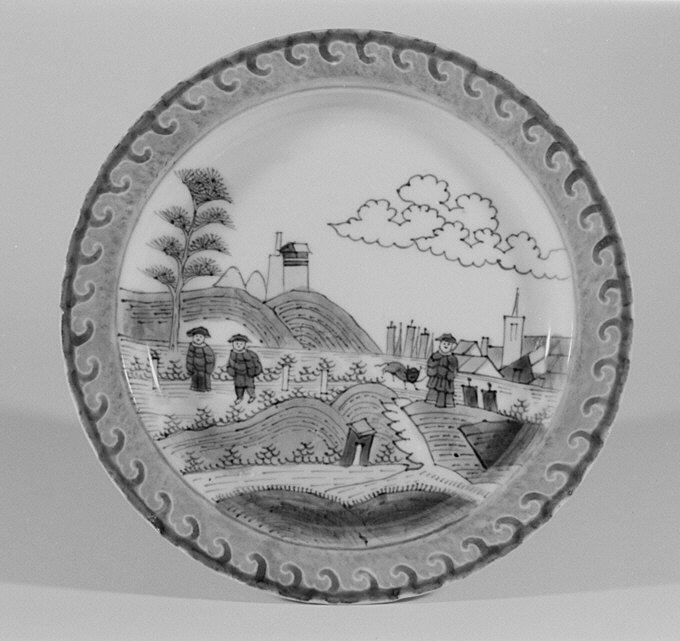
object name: plate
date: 1701-1733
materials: hard paste porcelain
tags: animals,men,trees